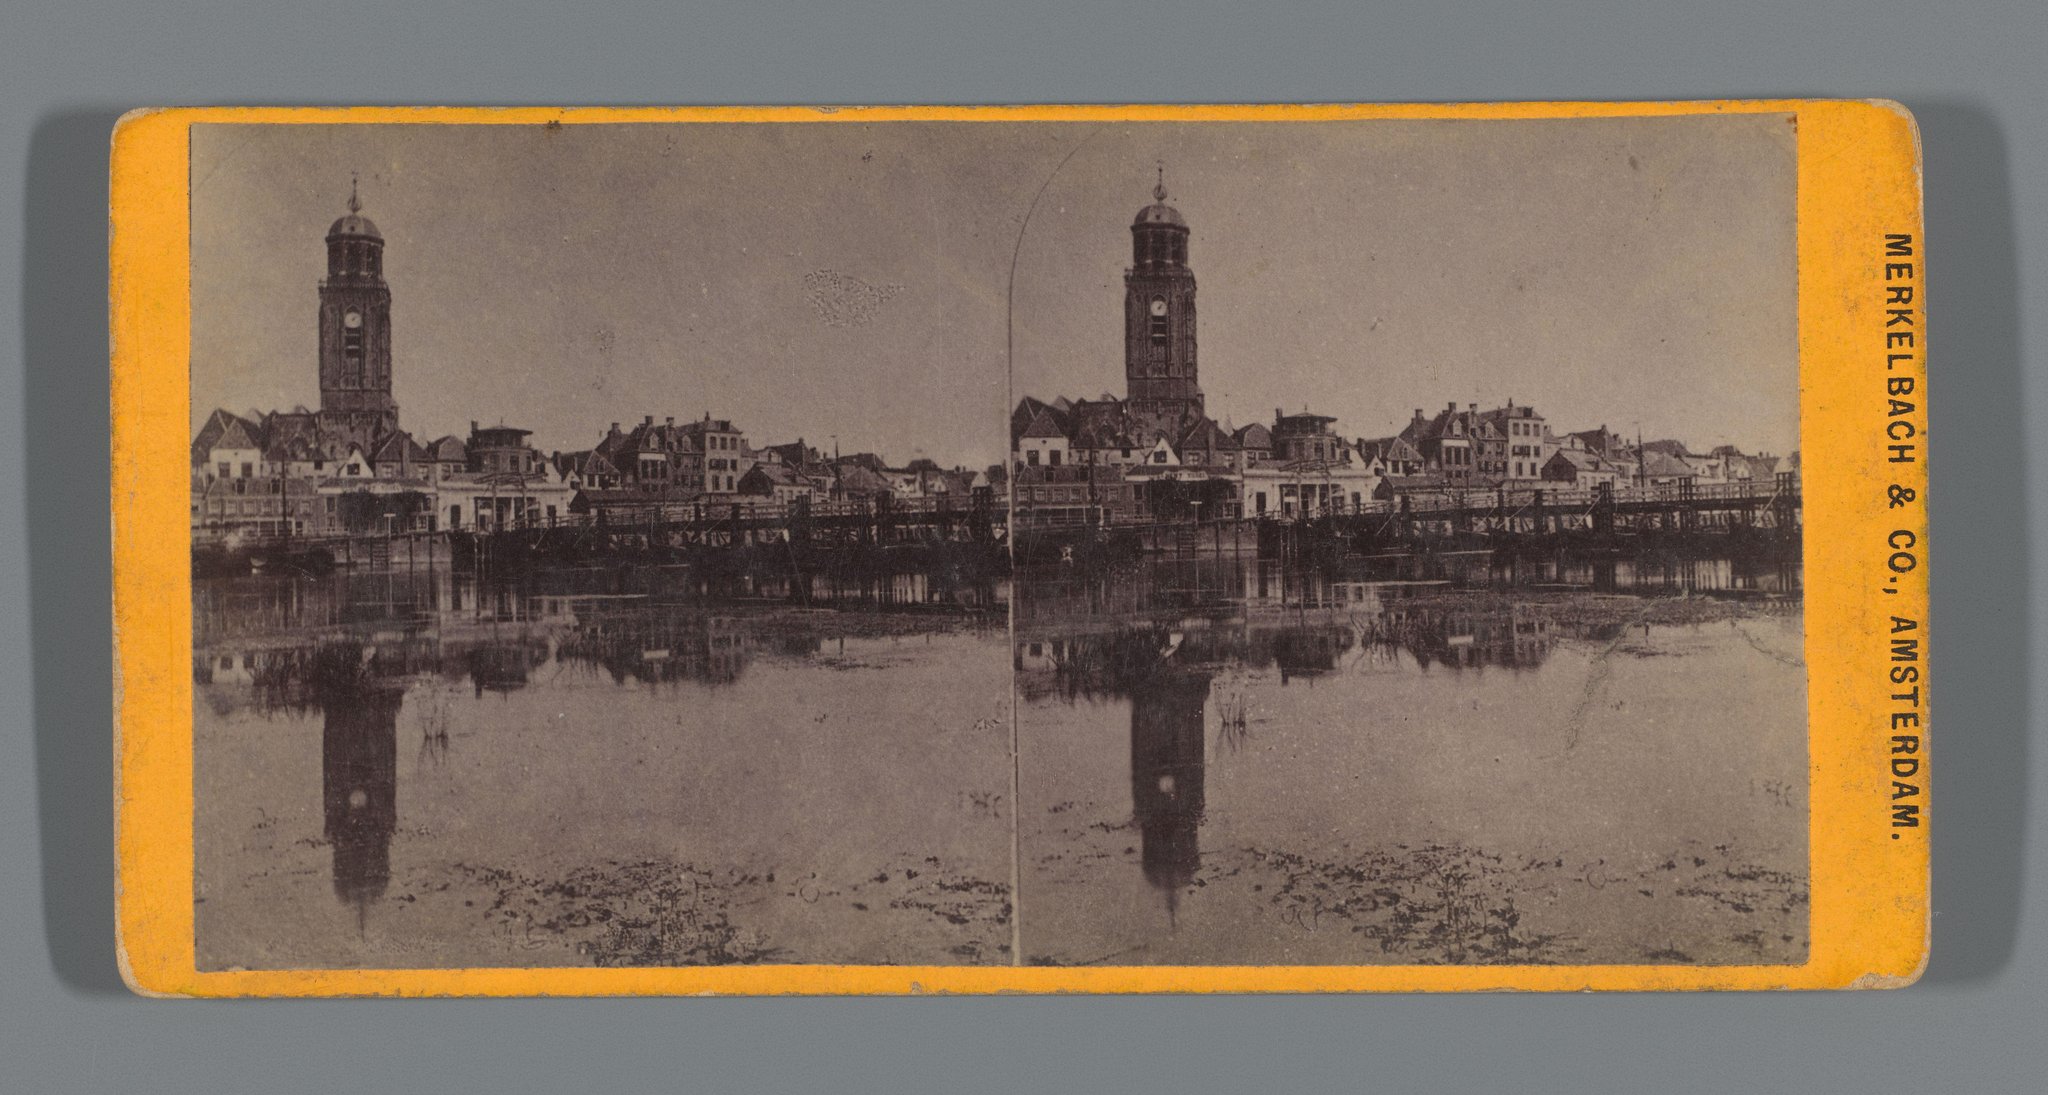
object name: stereograph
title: Aardrijkskundige Beeldengalerij, verzameld door M.J. Broekhuijsen, Hoofd eener school te Amsterdam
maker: martien johan broekhuijsen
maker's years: 1871-1956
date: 1905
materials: photographic support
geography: amsterdam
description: Onderdeel van een groep van 52 stereofoto's gebruikt in het lager onderwijs als aanvulling op schoolplaten. De gehele reeks bestond uit 274 nummers in 10 categorieën (A t/m K).